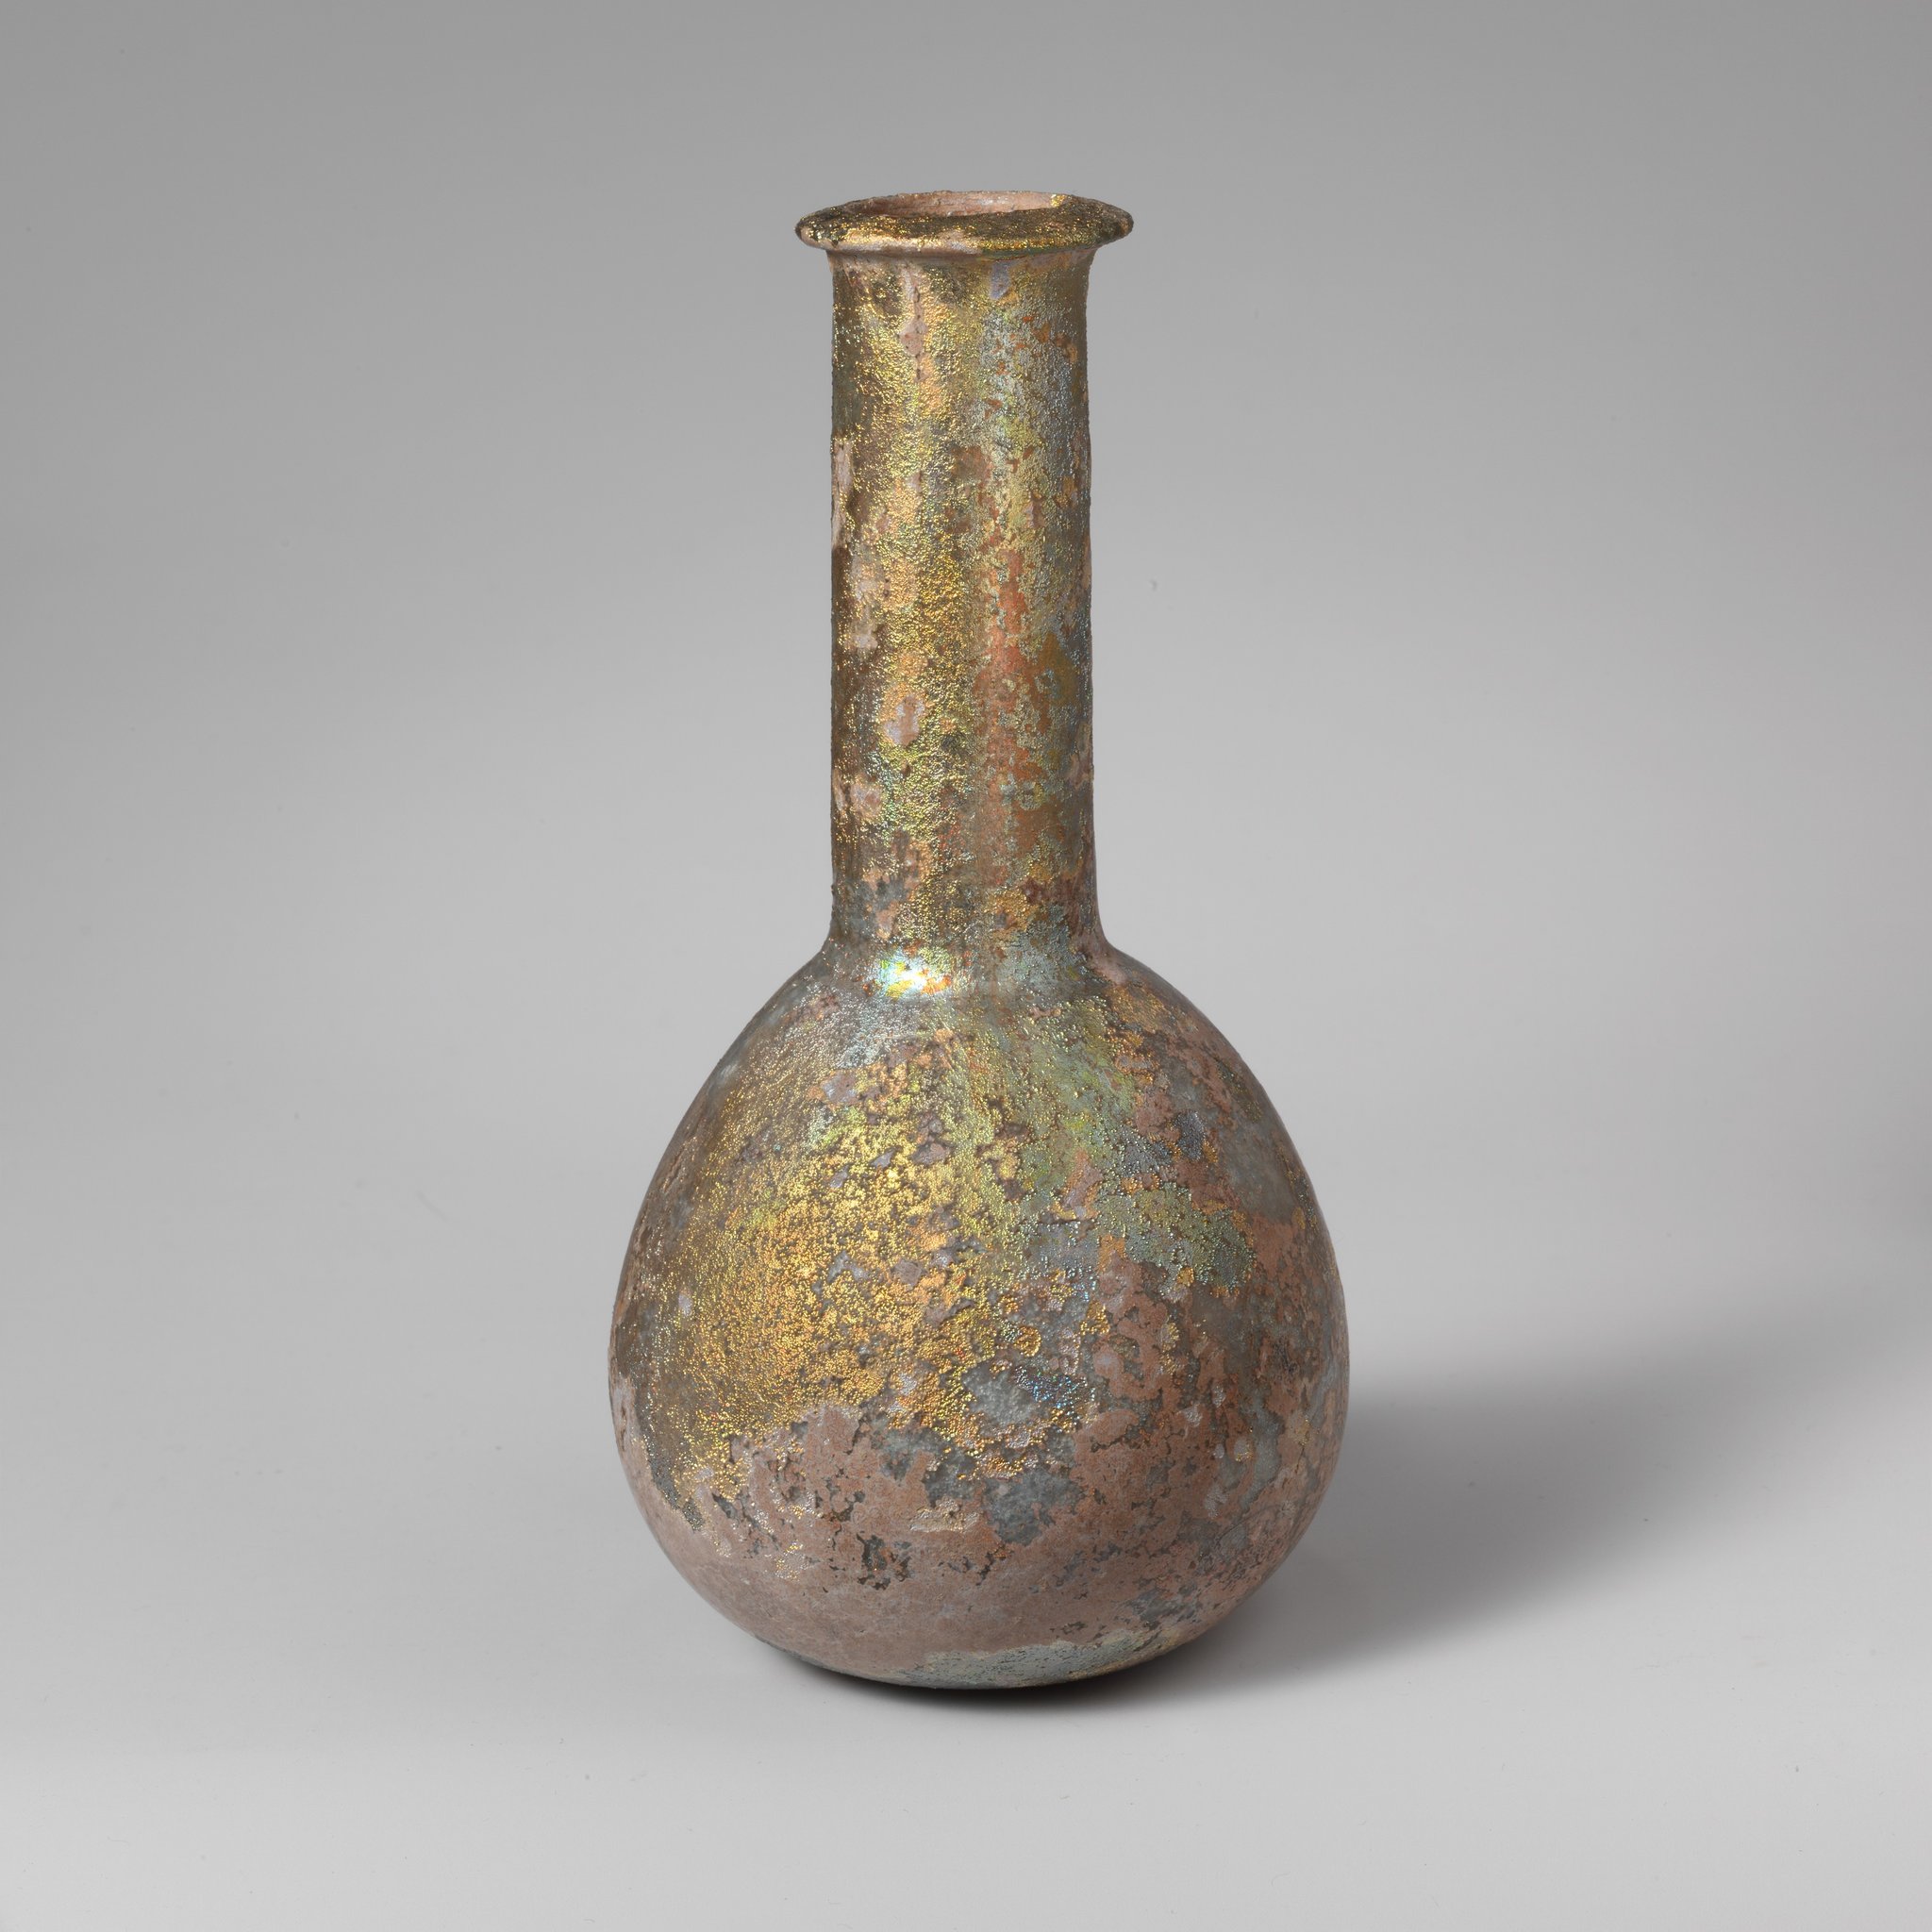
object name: perfume bottle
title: Glass perfume bottle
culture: roman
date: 101-300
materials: glass